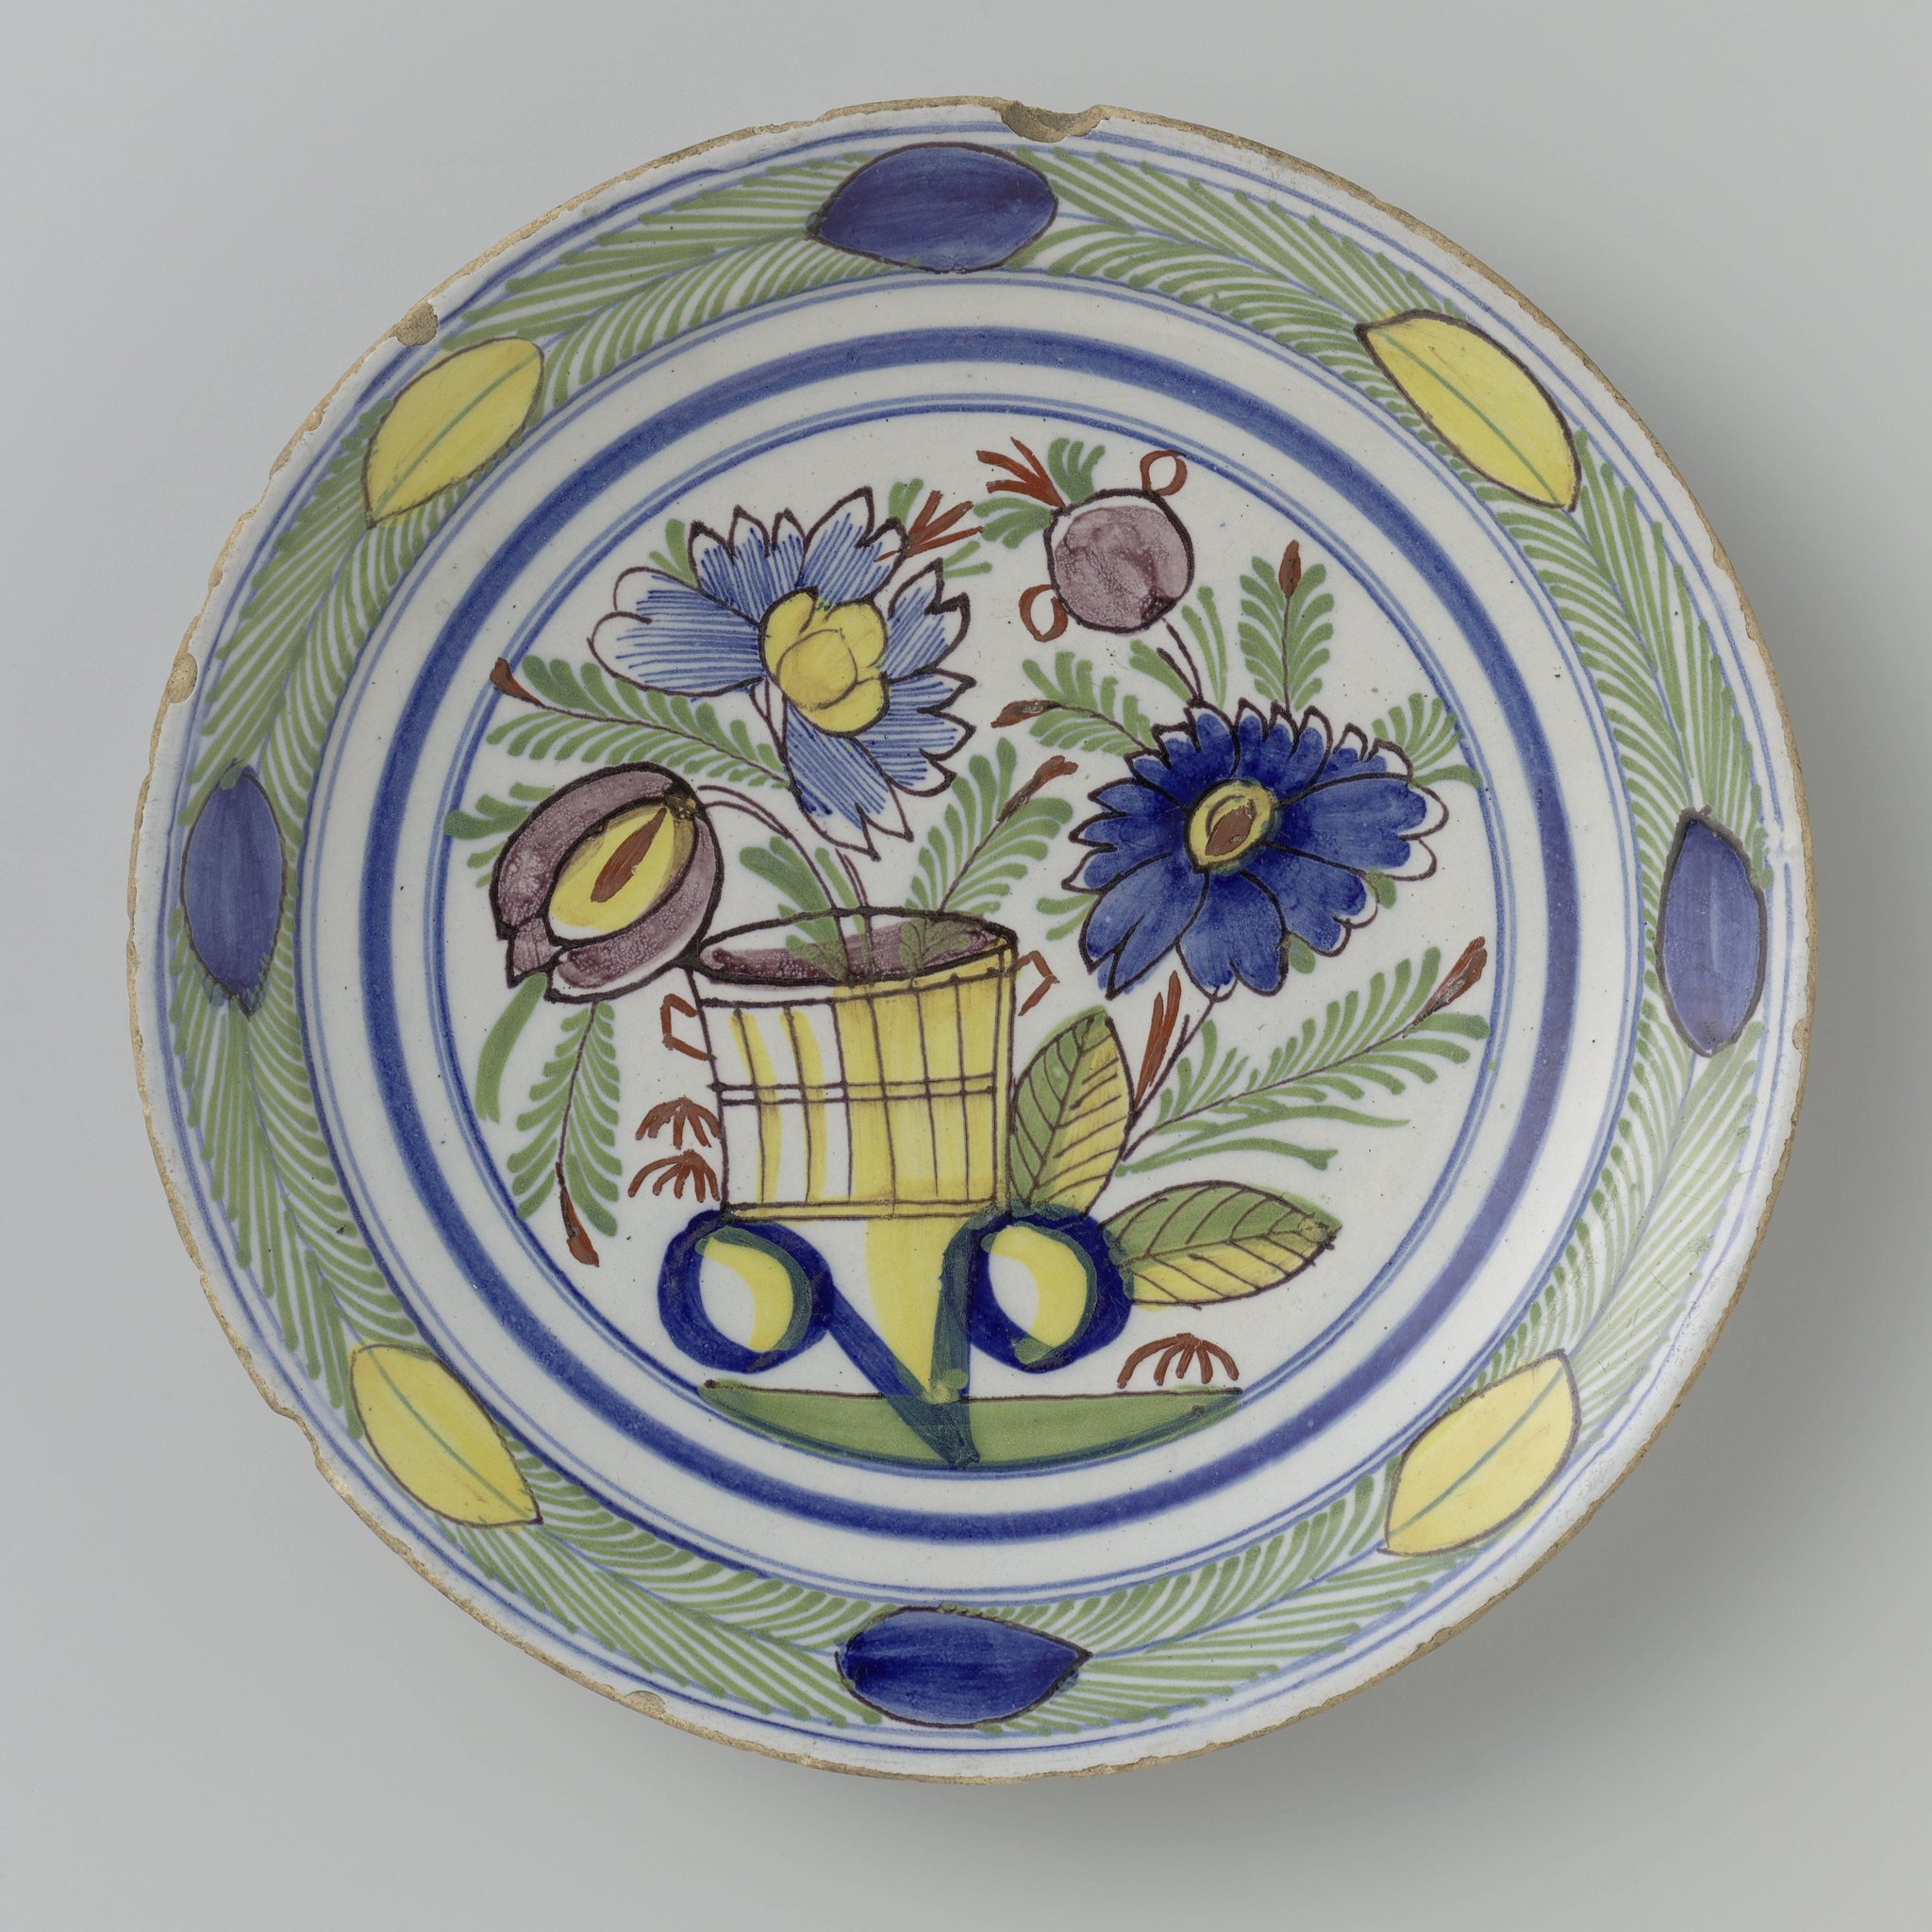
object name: plate dish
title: Bord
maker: Anonymous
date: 1750-1800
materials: earthenware, glaze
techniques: painted, polychromy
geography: delft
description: Rond bord van veelkleurig beschilderde faience. Op het bord is een pot met bloemen geschilderd.